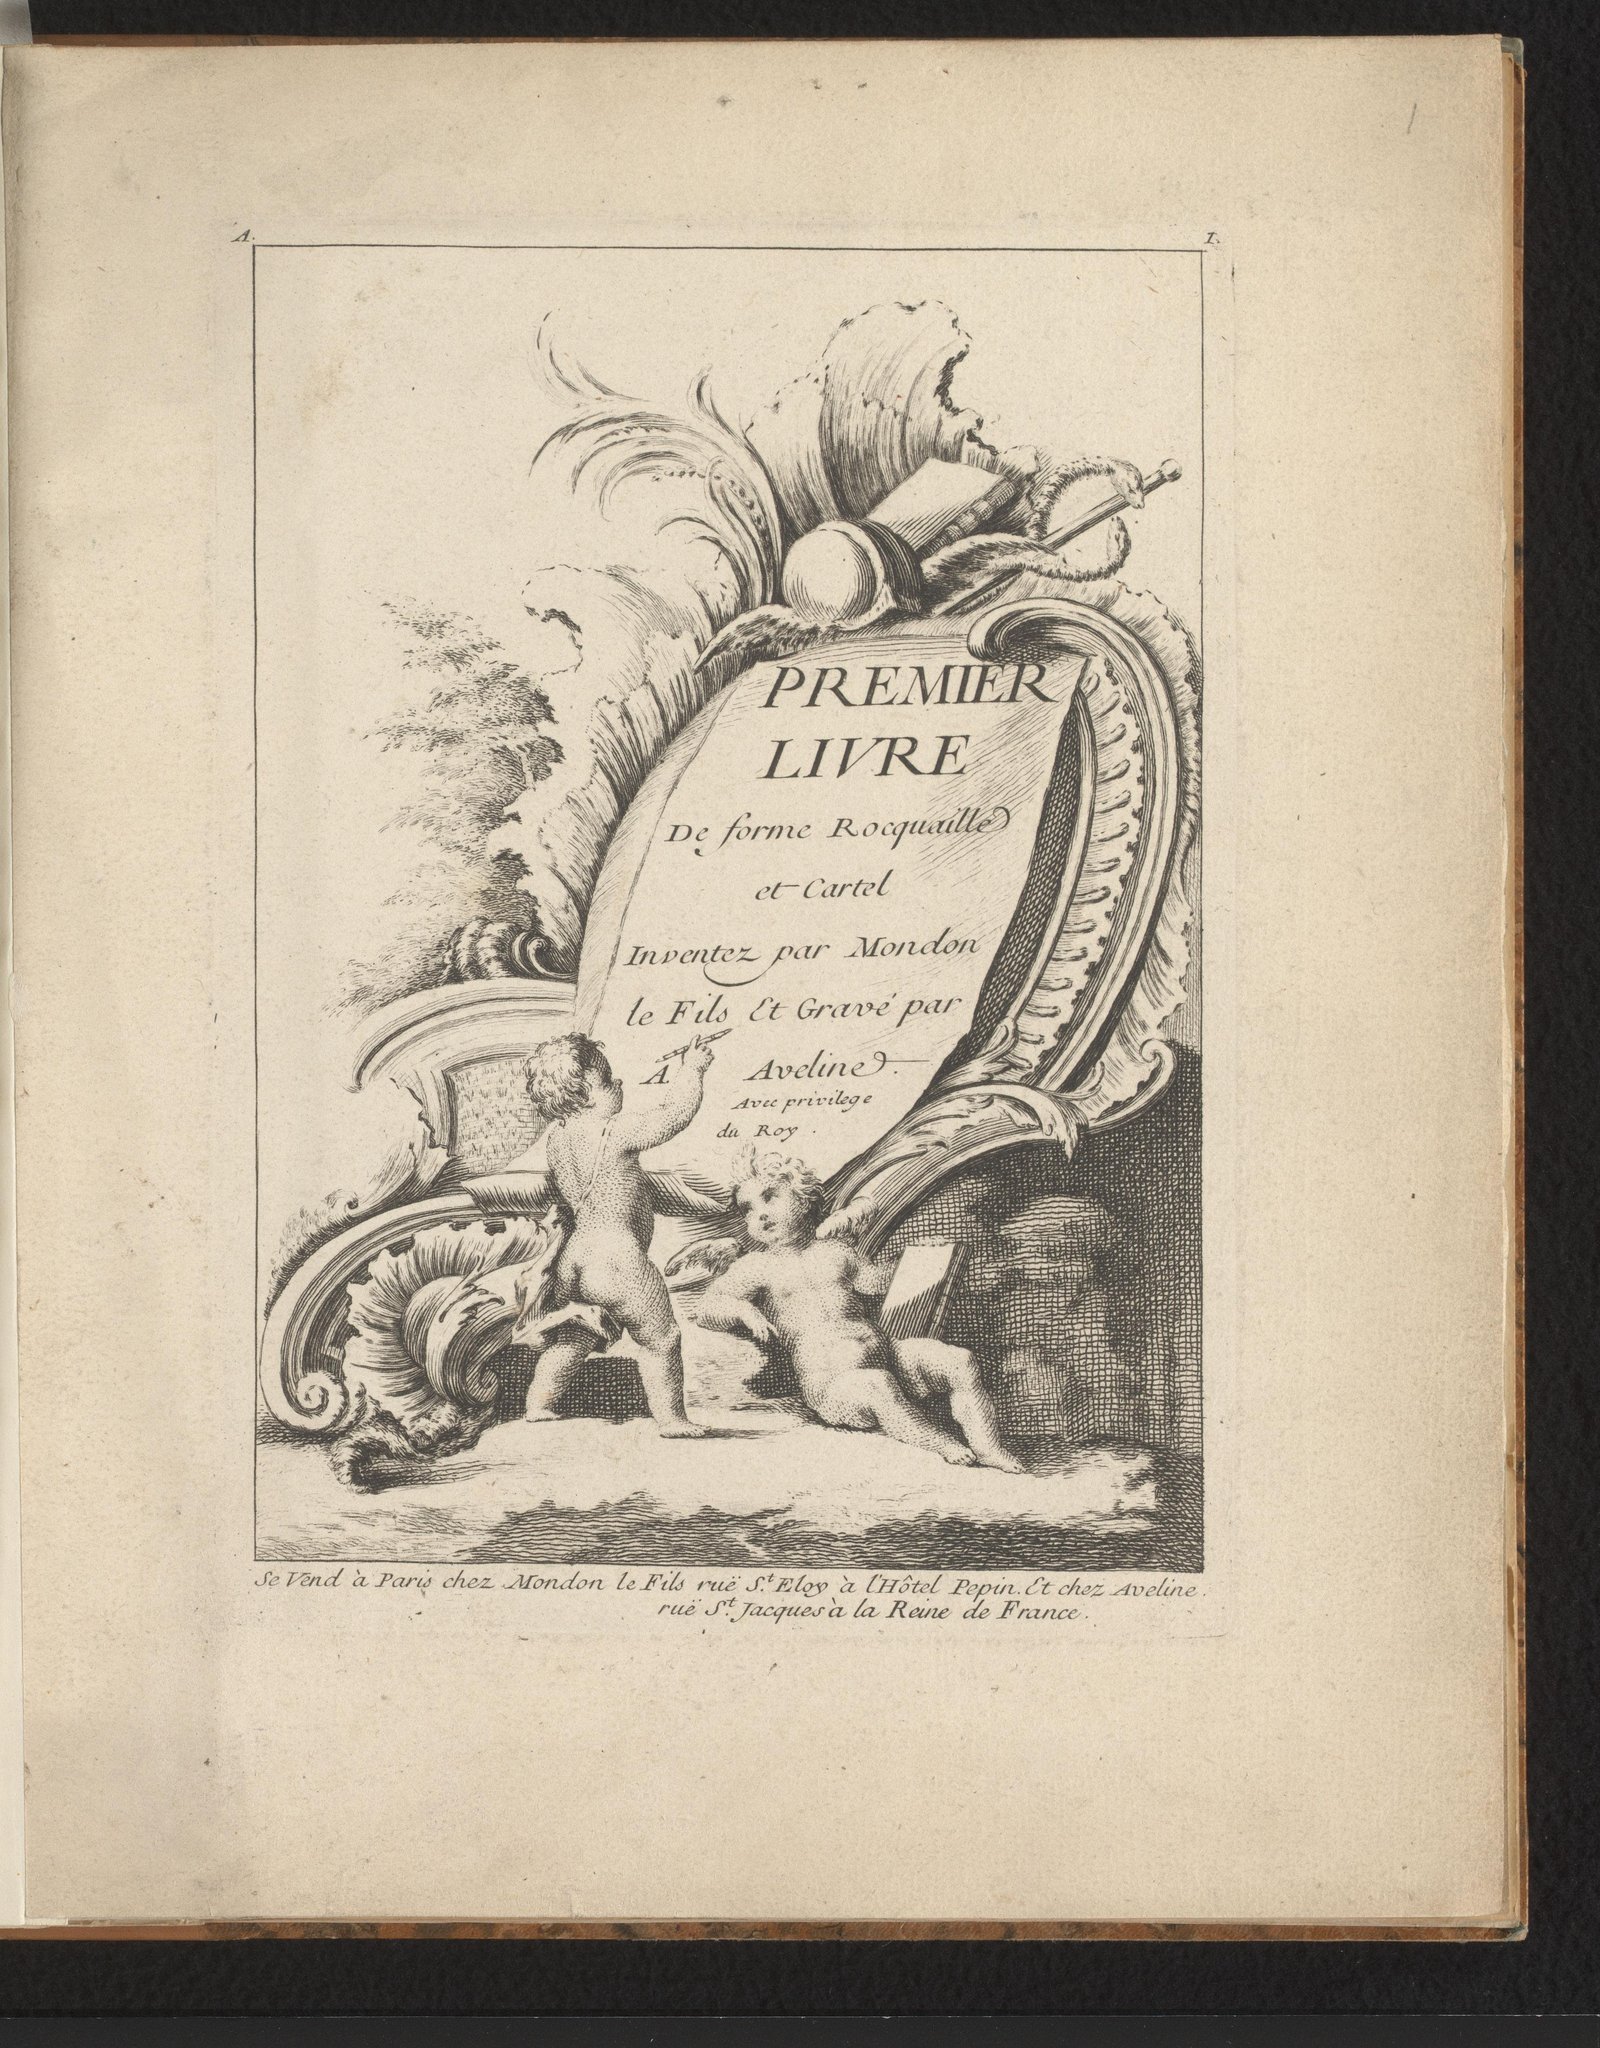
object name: print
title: Premier Livre de forme Rocquaille et Cartel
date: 1736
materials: paper, pencil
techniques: drawing, engraving, etching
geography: paris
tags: rocaille ornament, cupids: 'amores', 'amoretti', 'putti'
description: Deze serie is linksboven genummerd met een letter A. Op verso de omtrek van de putti in potlood. Prent maakt deel uit van een album.